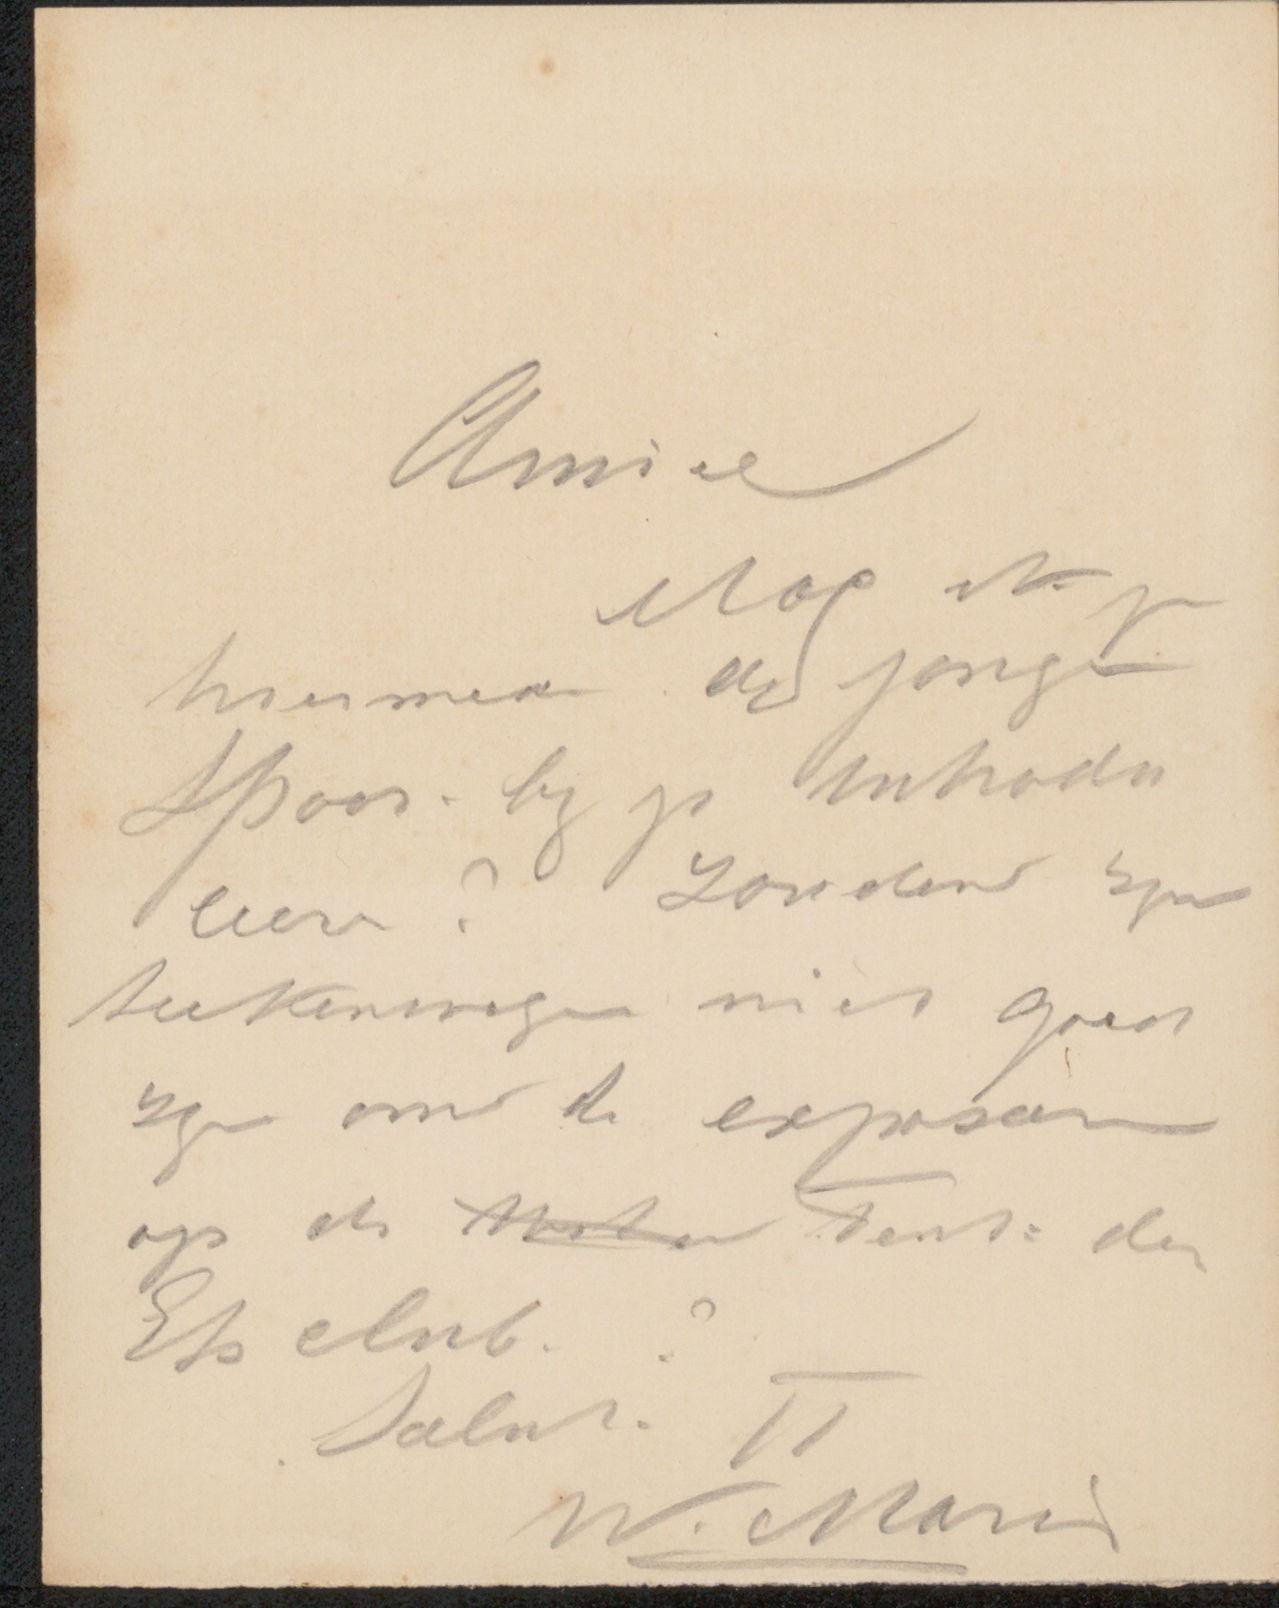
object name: letter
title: Brief aan Philip Zilcken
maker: willem maris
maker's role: draughtsman, painter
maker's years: 1844-1910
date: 1854-1910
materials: cardboard, ink, pencil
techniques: writing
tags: painter, draughtsman, philip zilcken, drawing, exhibition ~ art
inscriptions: collector's mark: ‘RPK’